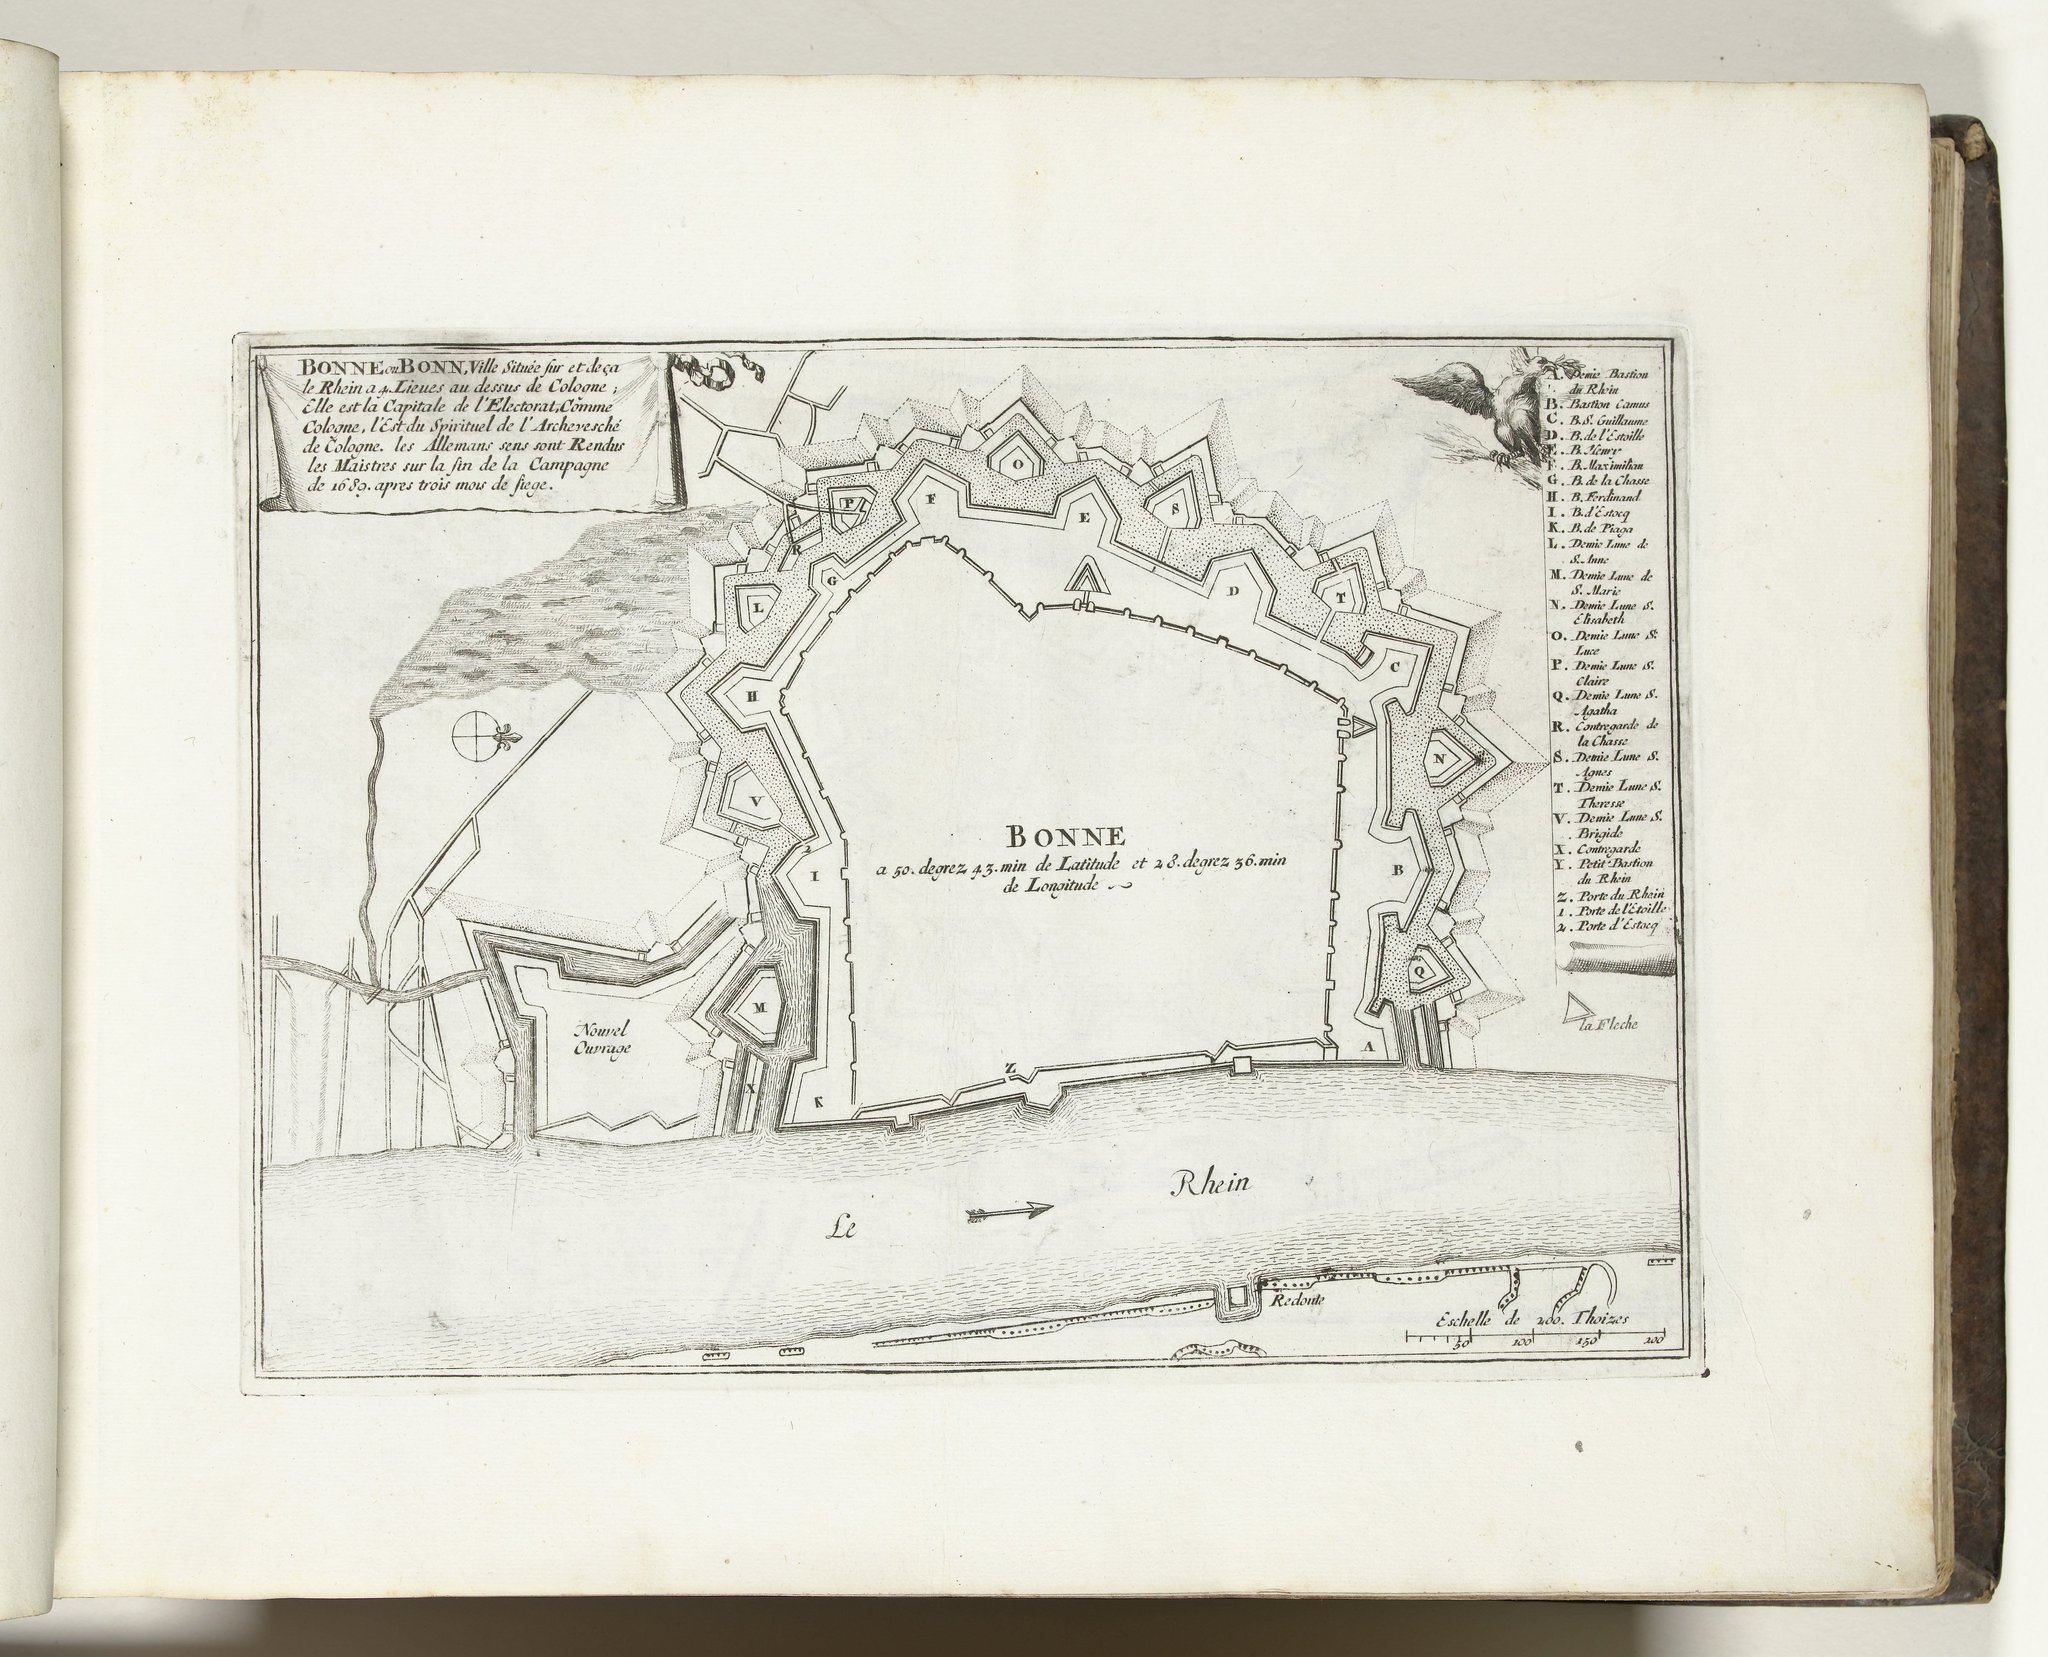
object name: print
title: Plattegrond van Bonn, 1693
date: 1693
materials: paper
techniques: etching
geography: france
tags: fortress, maps of cities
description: Plattegrond van de fortificaties rond de stad Bonn. Onderdeel van het eerste deel (1693) van het prentwerk waarin gebundeld zijn de acht delen van Les forces de l'Europe uitgegeven tussen 1693-1697. Het prentwerk bestaat uit 175 platen met plannen (afkomstig van Sébastien Le Prestre, Seigneur de Vauban) van vermaarde sterke steden en vestingen in de Negenjarige Oorlog. Titel en opschriften in het Frans.